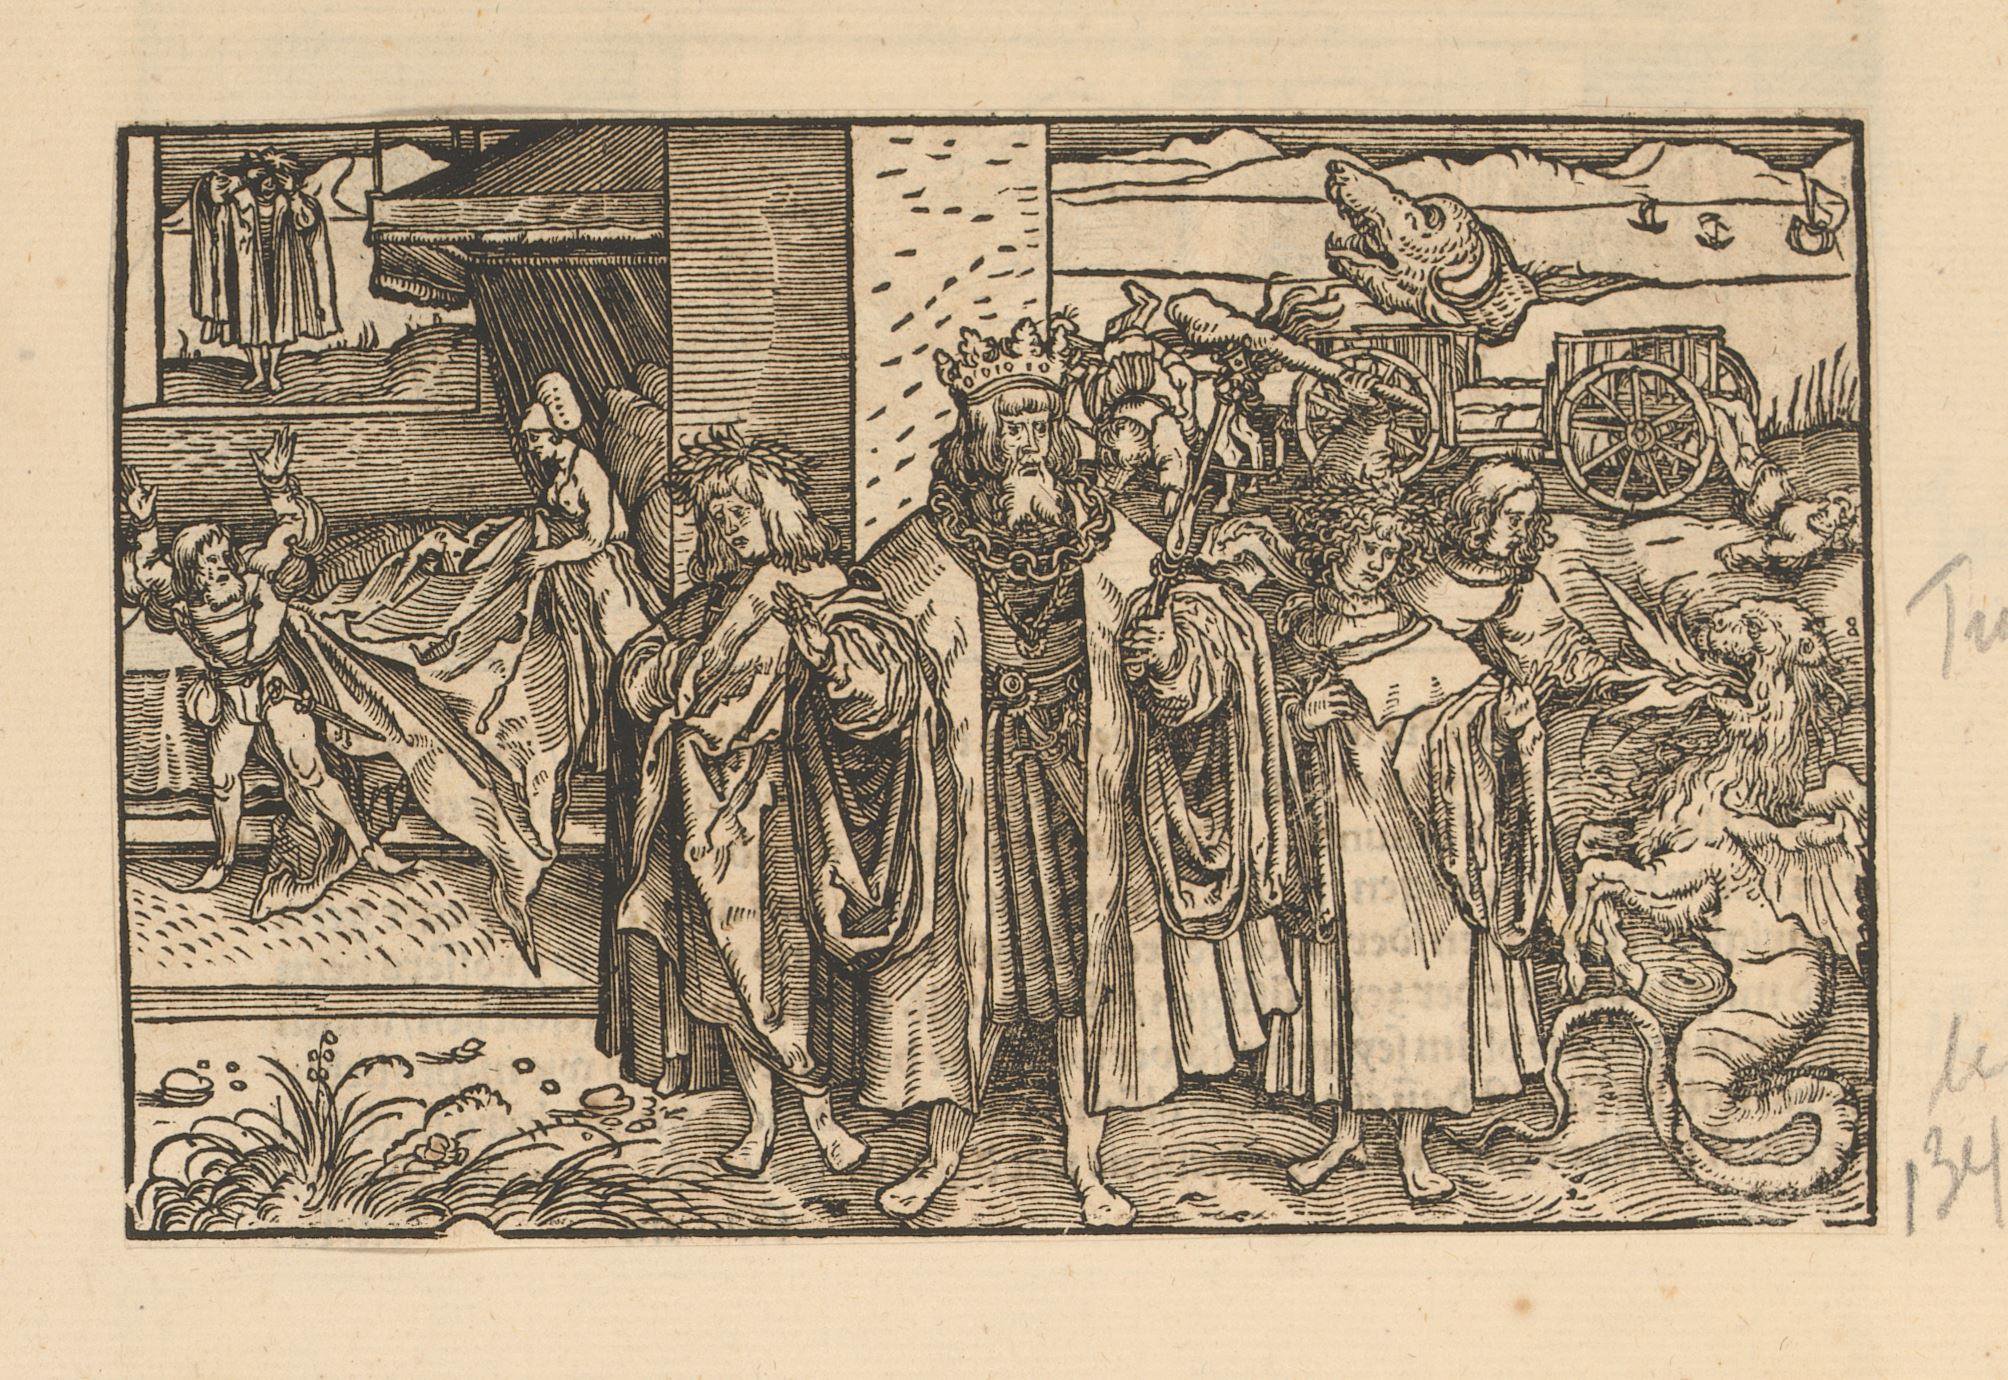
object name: book illustration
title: Twee jonge mannen bij een gekroonde man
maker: Anonymous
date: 1514-1532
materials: paper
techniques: letterpress printing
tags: correction of naughty children, good and bad behaviour, moral qualities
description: Deze prent is gebruikt in: Petrarca, Francesco. Von der Artzney bayder Glück, des guten und widerwertigen: unnd weß sich ain yeder inn Gelück und Unglück halten sol (...). Augsburg: Heinrich Steiner, 1532. Deze uitgave is ook bekend onder de titel 'Trostspiegel in Glück und Unglück'.